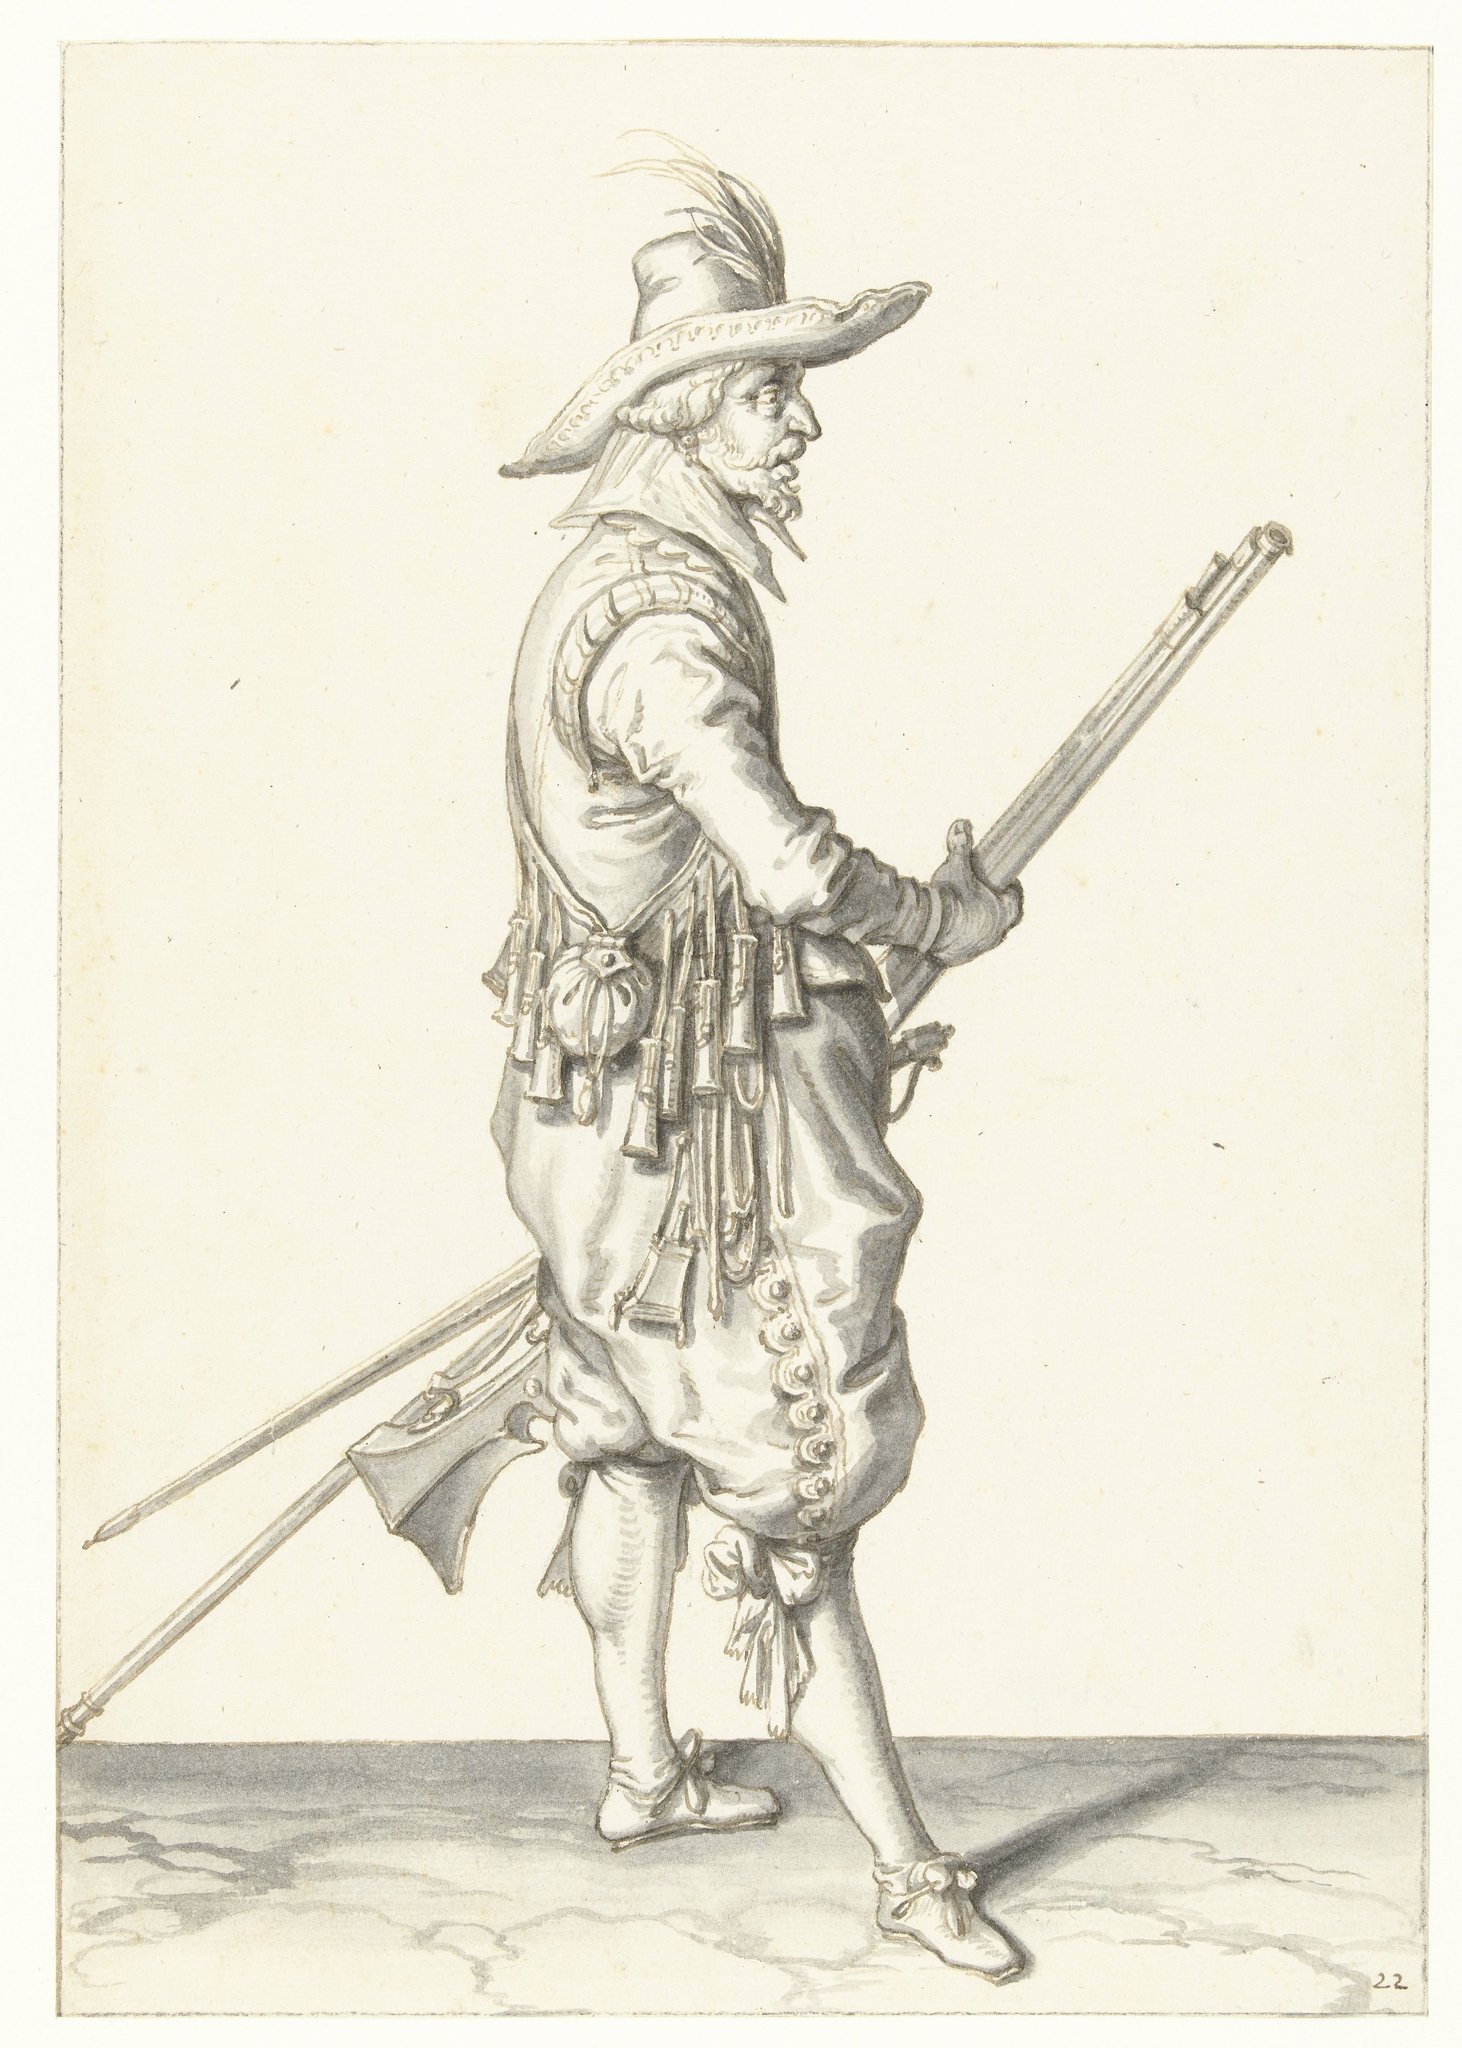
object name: design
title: Soldaat die zijn musket met beide handen bij zijn linkerdijbeen vasthoudt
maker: jacques de gheyn (ii)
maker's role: painter, print maker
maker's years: 1565-1629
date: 1596-1606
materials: ink, paper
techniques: brush, pen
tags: handling of weapons ~ military training